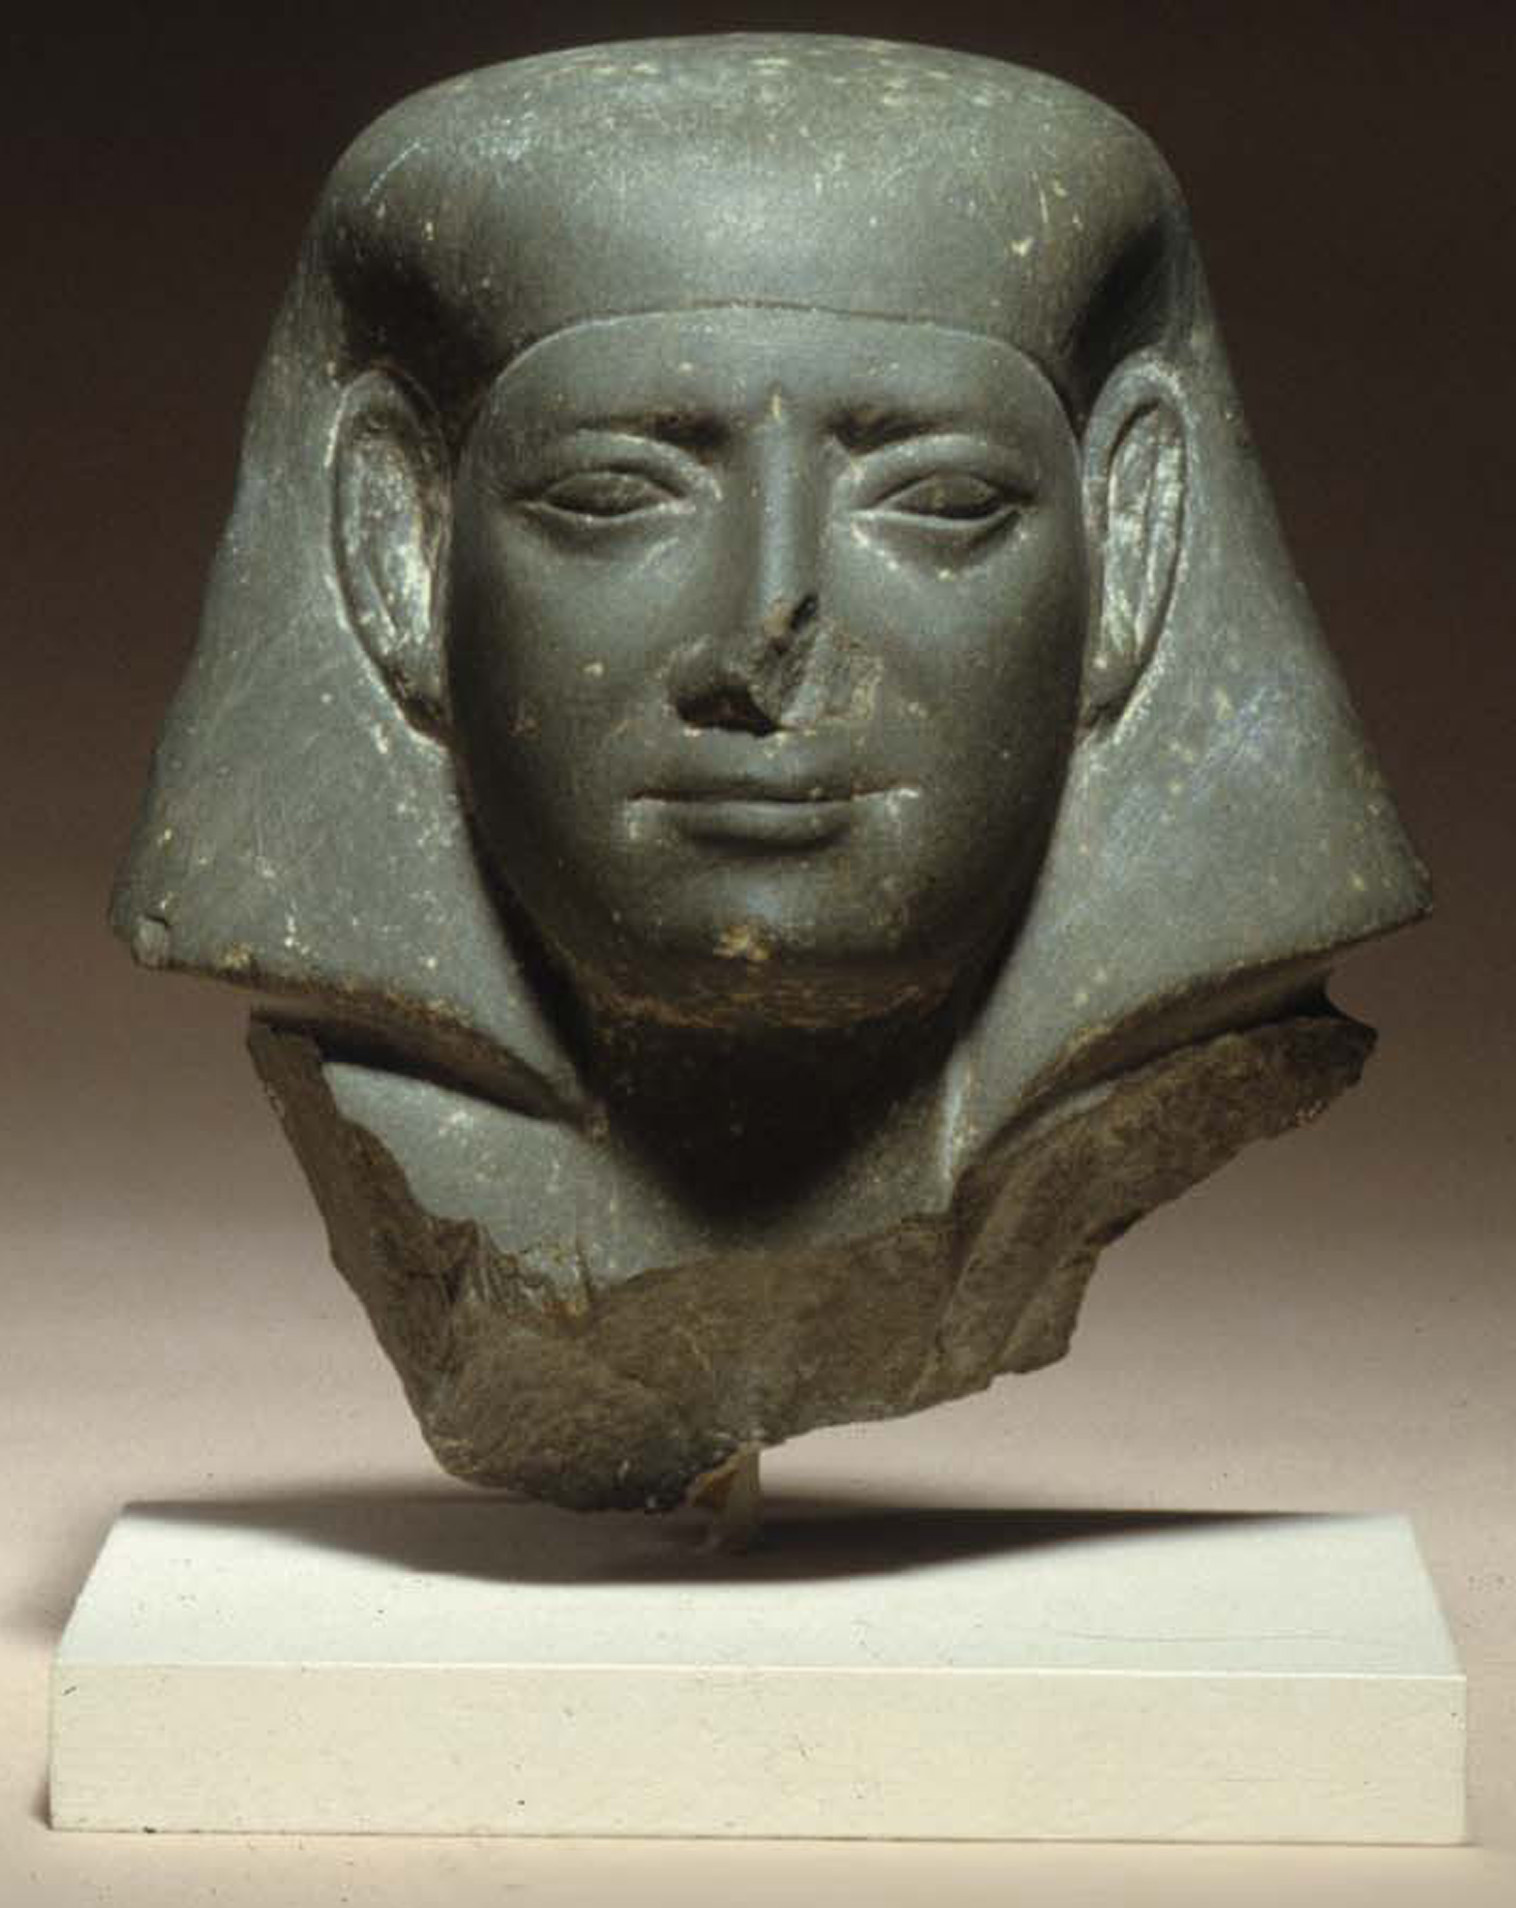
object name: head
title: Head of a male statue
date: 1981-1550 BCE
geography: egypt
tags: heads,men